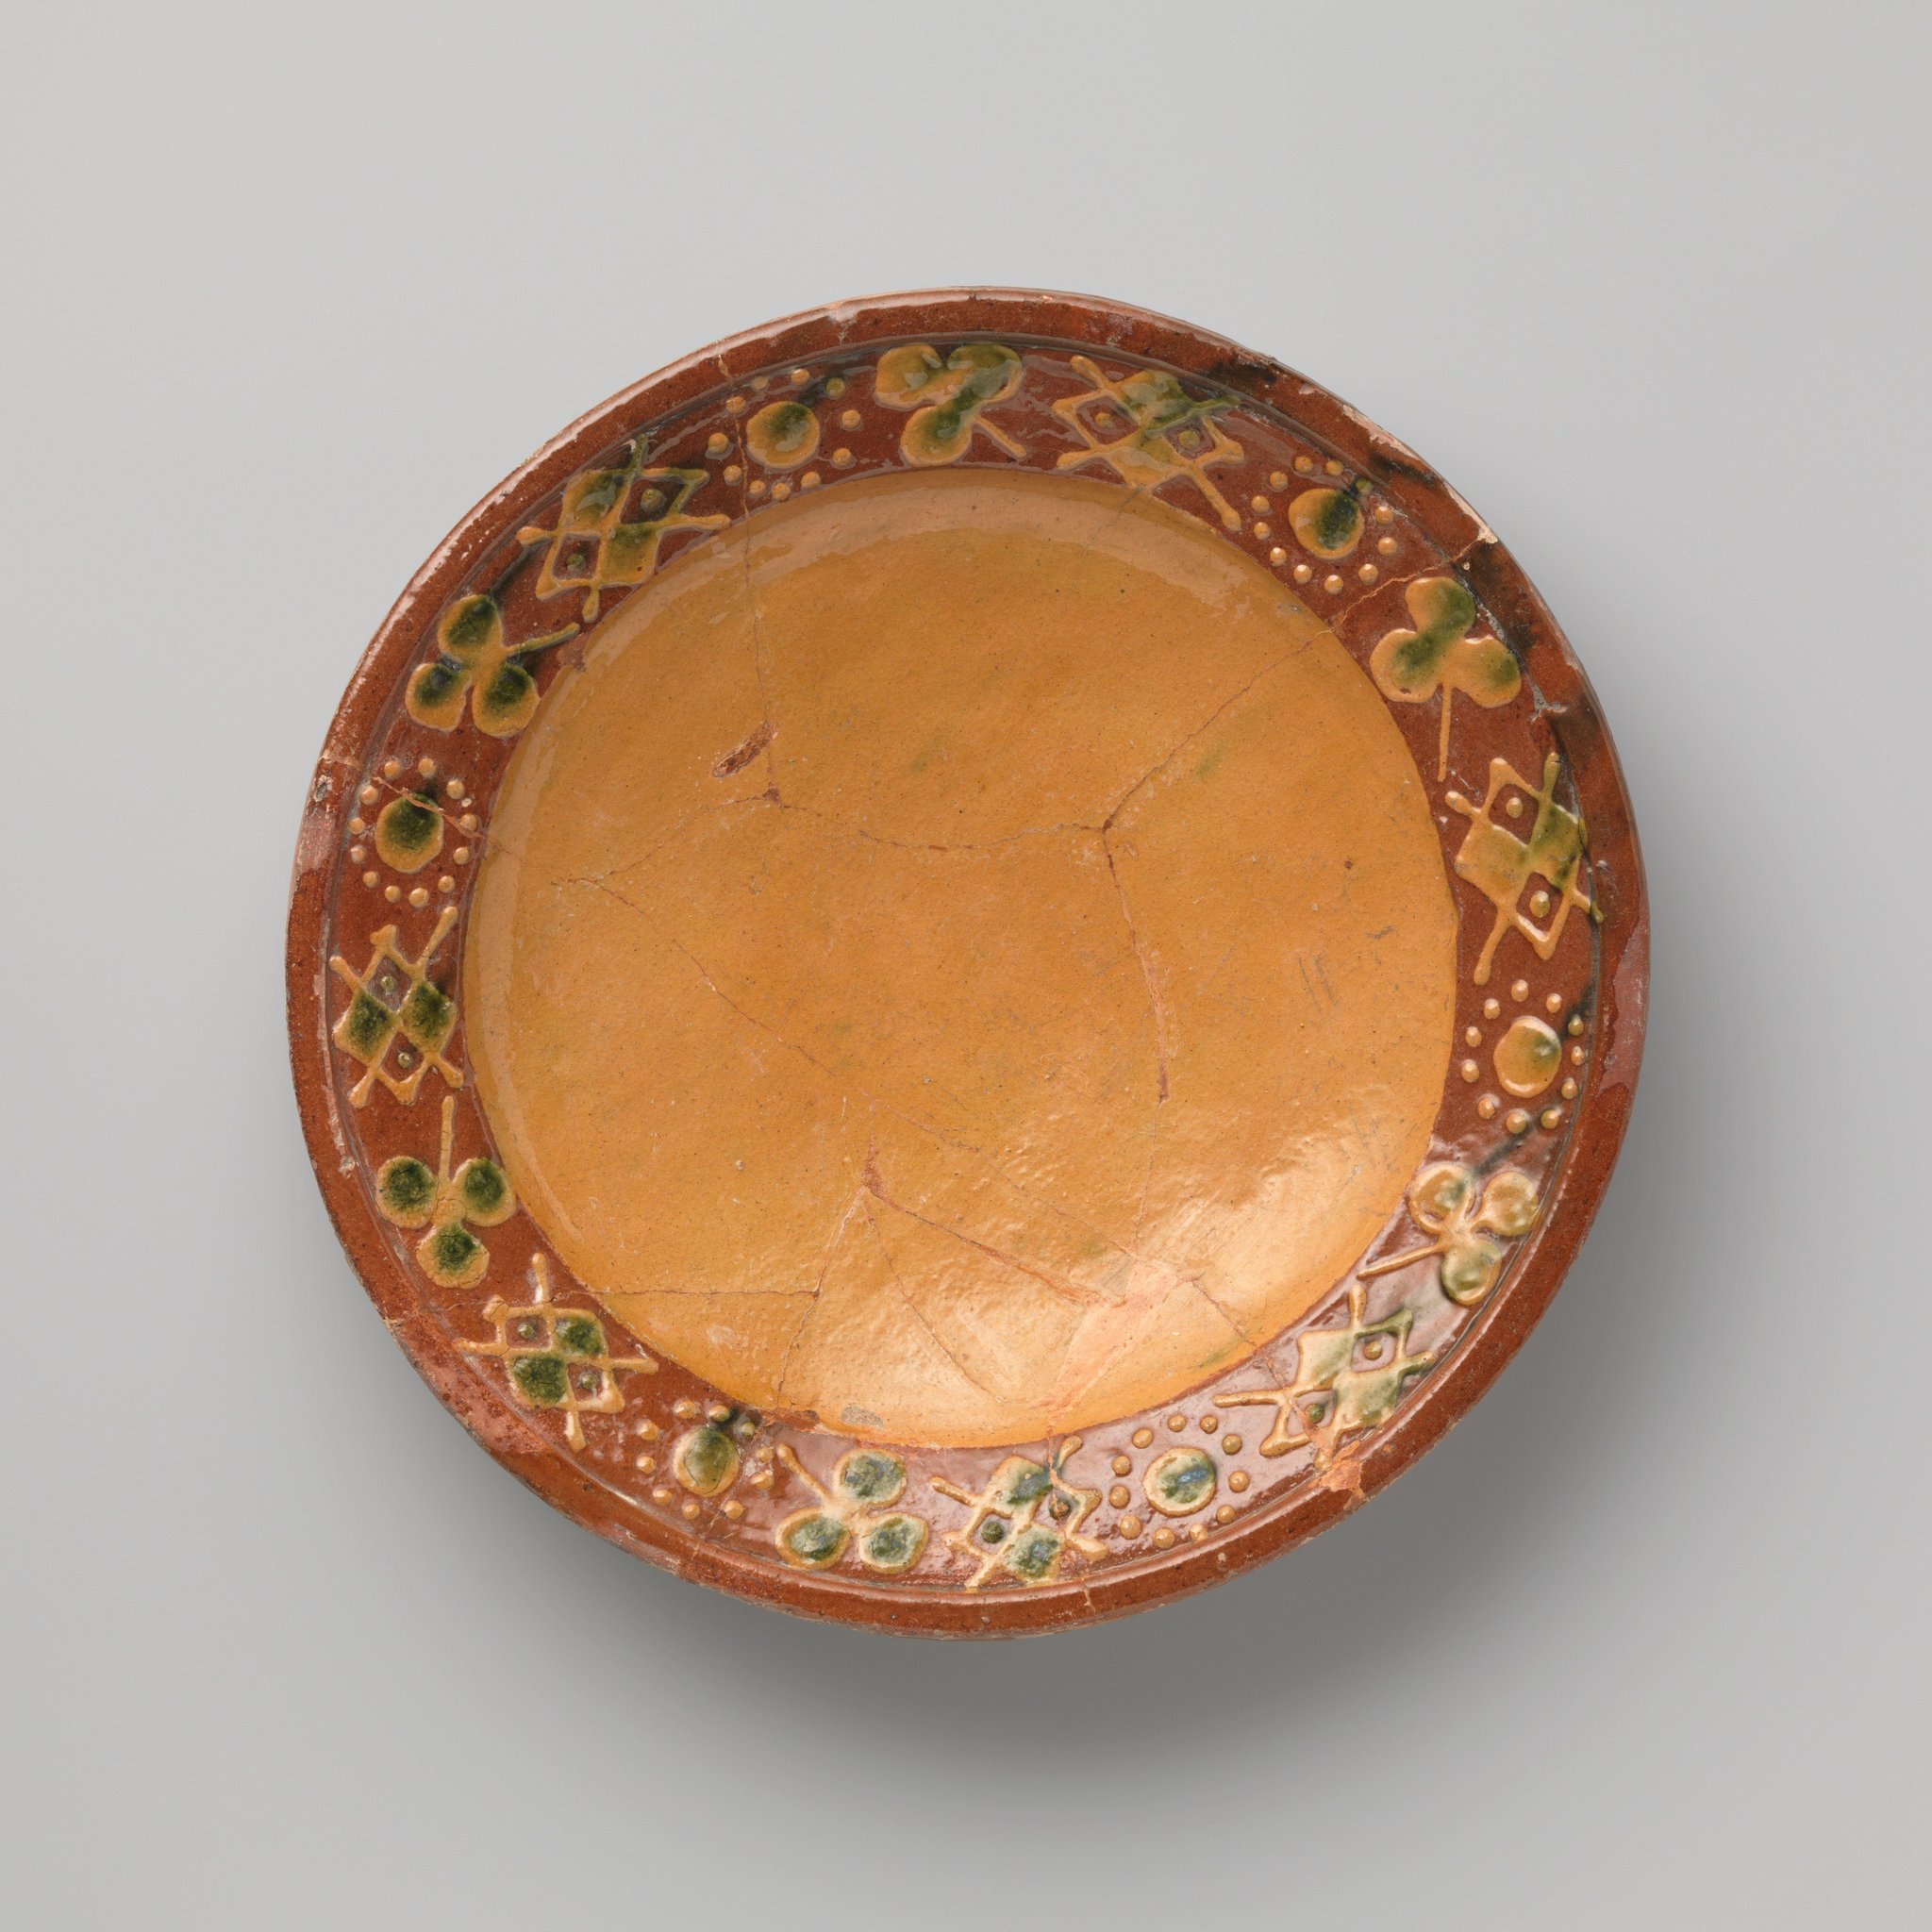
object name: bowl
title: Kom met twee oren, versierd met een hert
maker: Anonymous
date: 1600-1625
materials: earthenware, glaze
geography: north holland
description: Kom van loodglazuuraardewerk, met twee oren. De kom is in witte slib versierd met een hert en is bedekt met plaatselijk groen getinte loodglazuur.